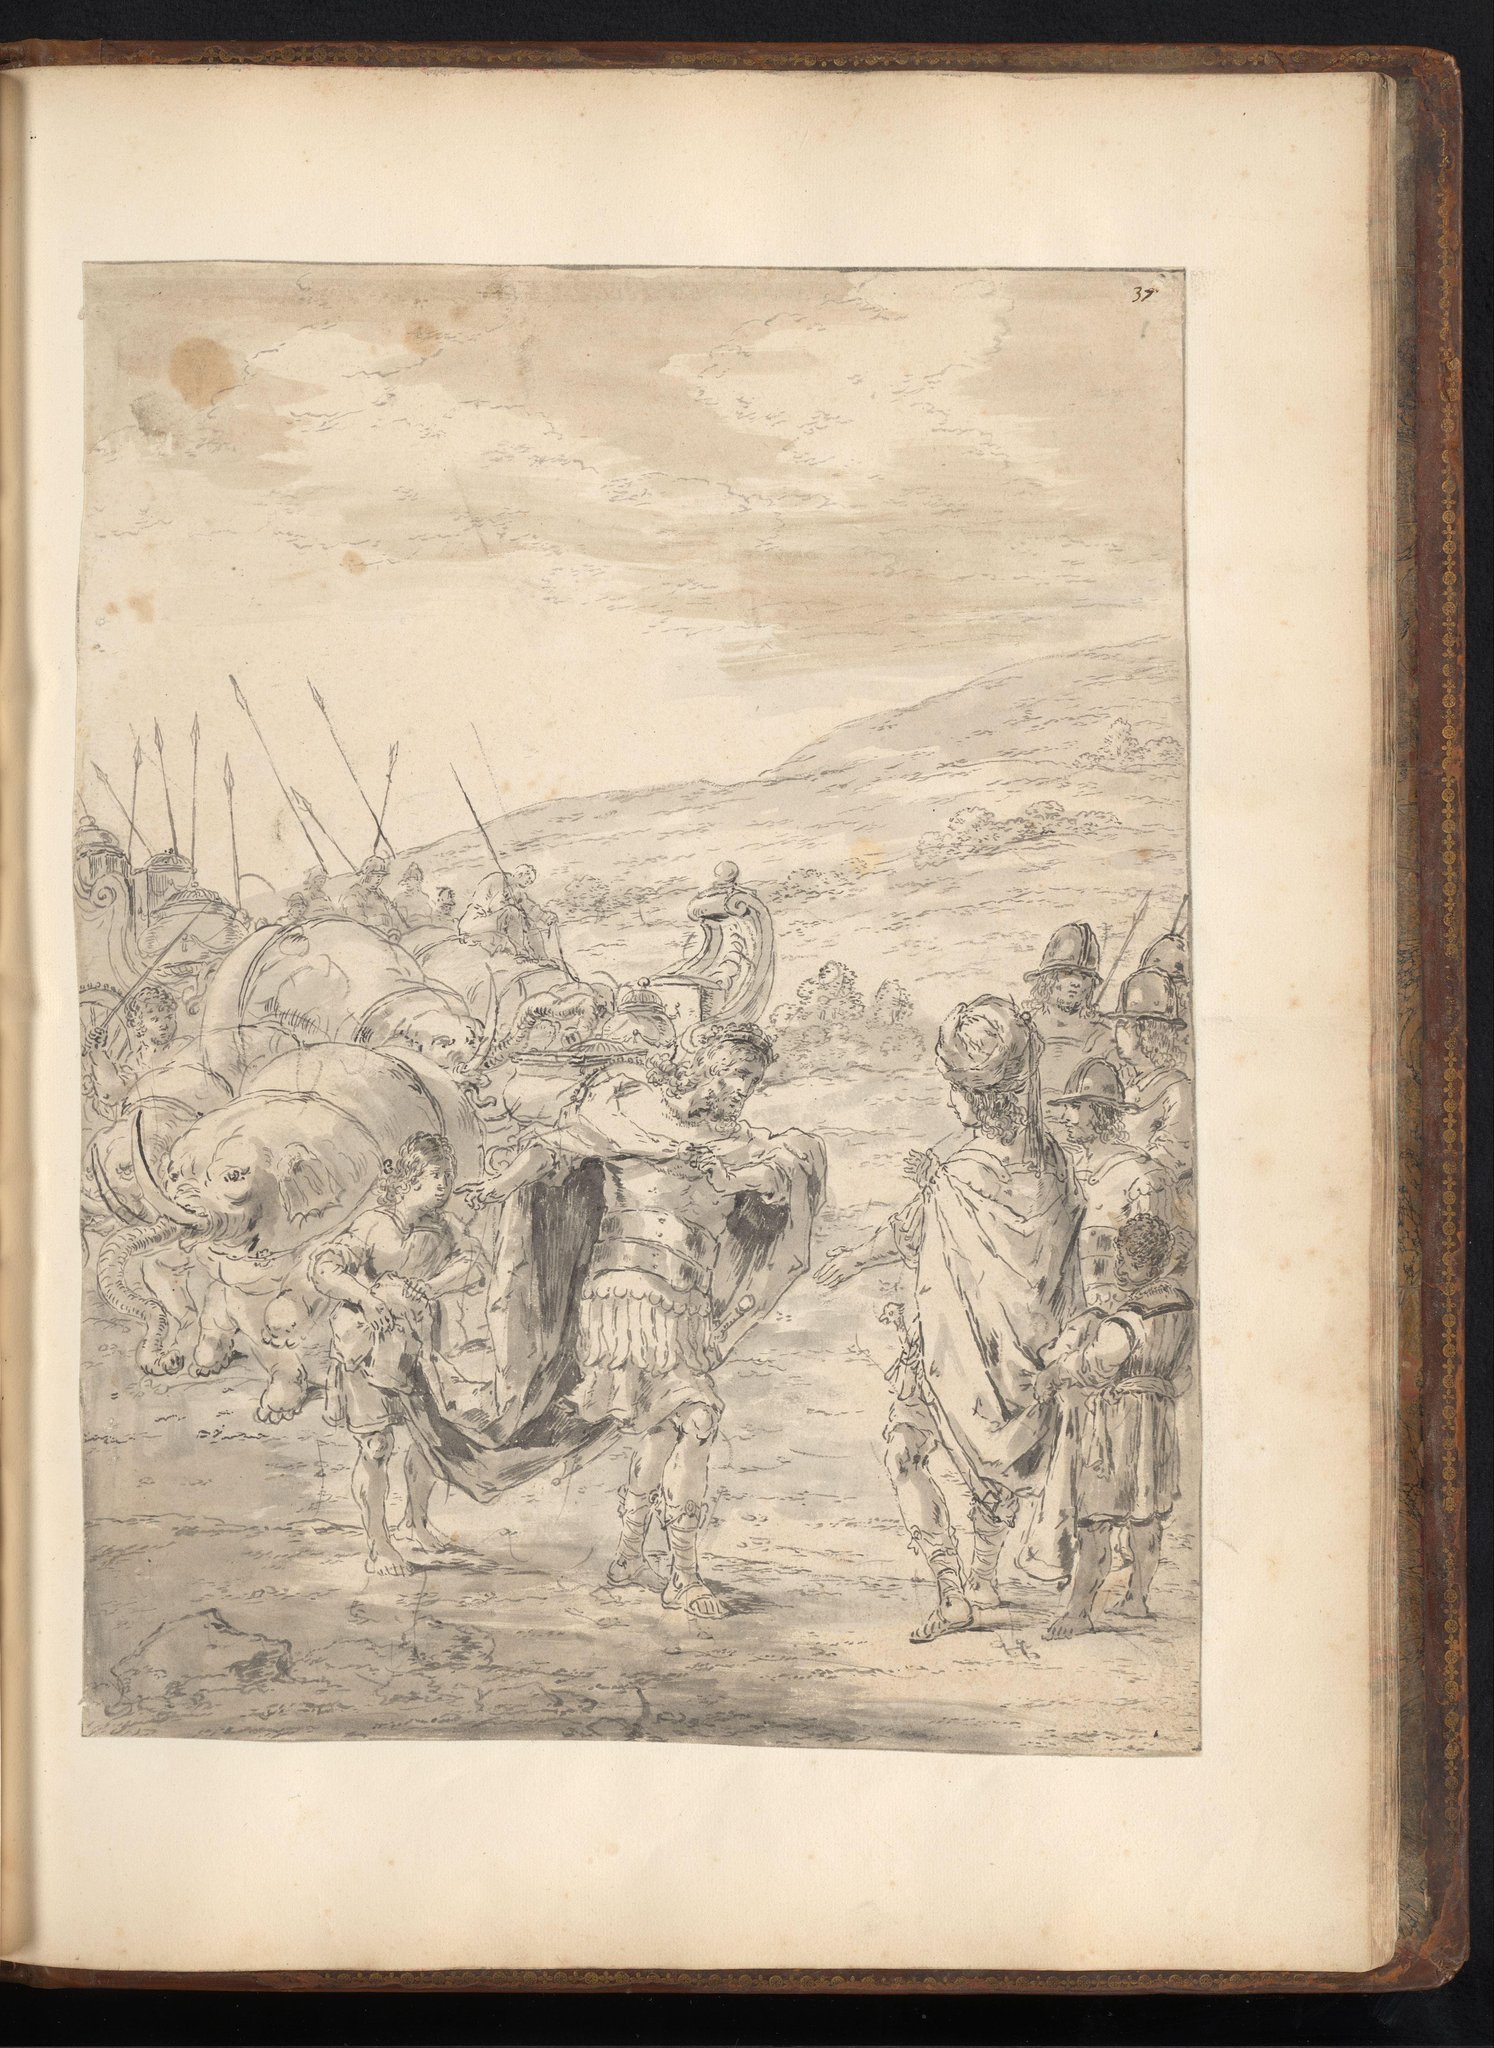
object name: album leaf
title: Alexander de Grote ontmoet koning Taxiles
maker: leonaert bramer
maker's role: draughtsman, painter, print maker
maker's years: 1596-1674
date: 1655-1665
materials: ink, paper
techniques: brush, pen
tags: (story of) alexander the great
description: Alexander de Grote en zijn gevolg staan rechts. Links komt een stoet met wagens en olifanten langs, met voorop koning Taxiles, die richting Alexander de Grote loopt. Rechtsboven genummerd: 37. Rechtsonder genummerd: 1. Tekening maakt deel uit van een album.